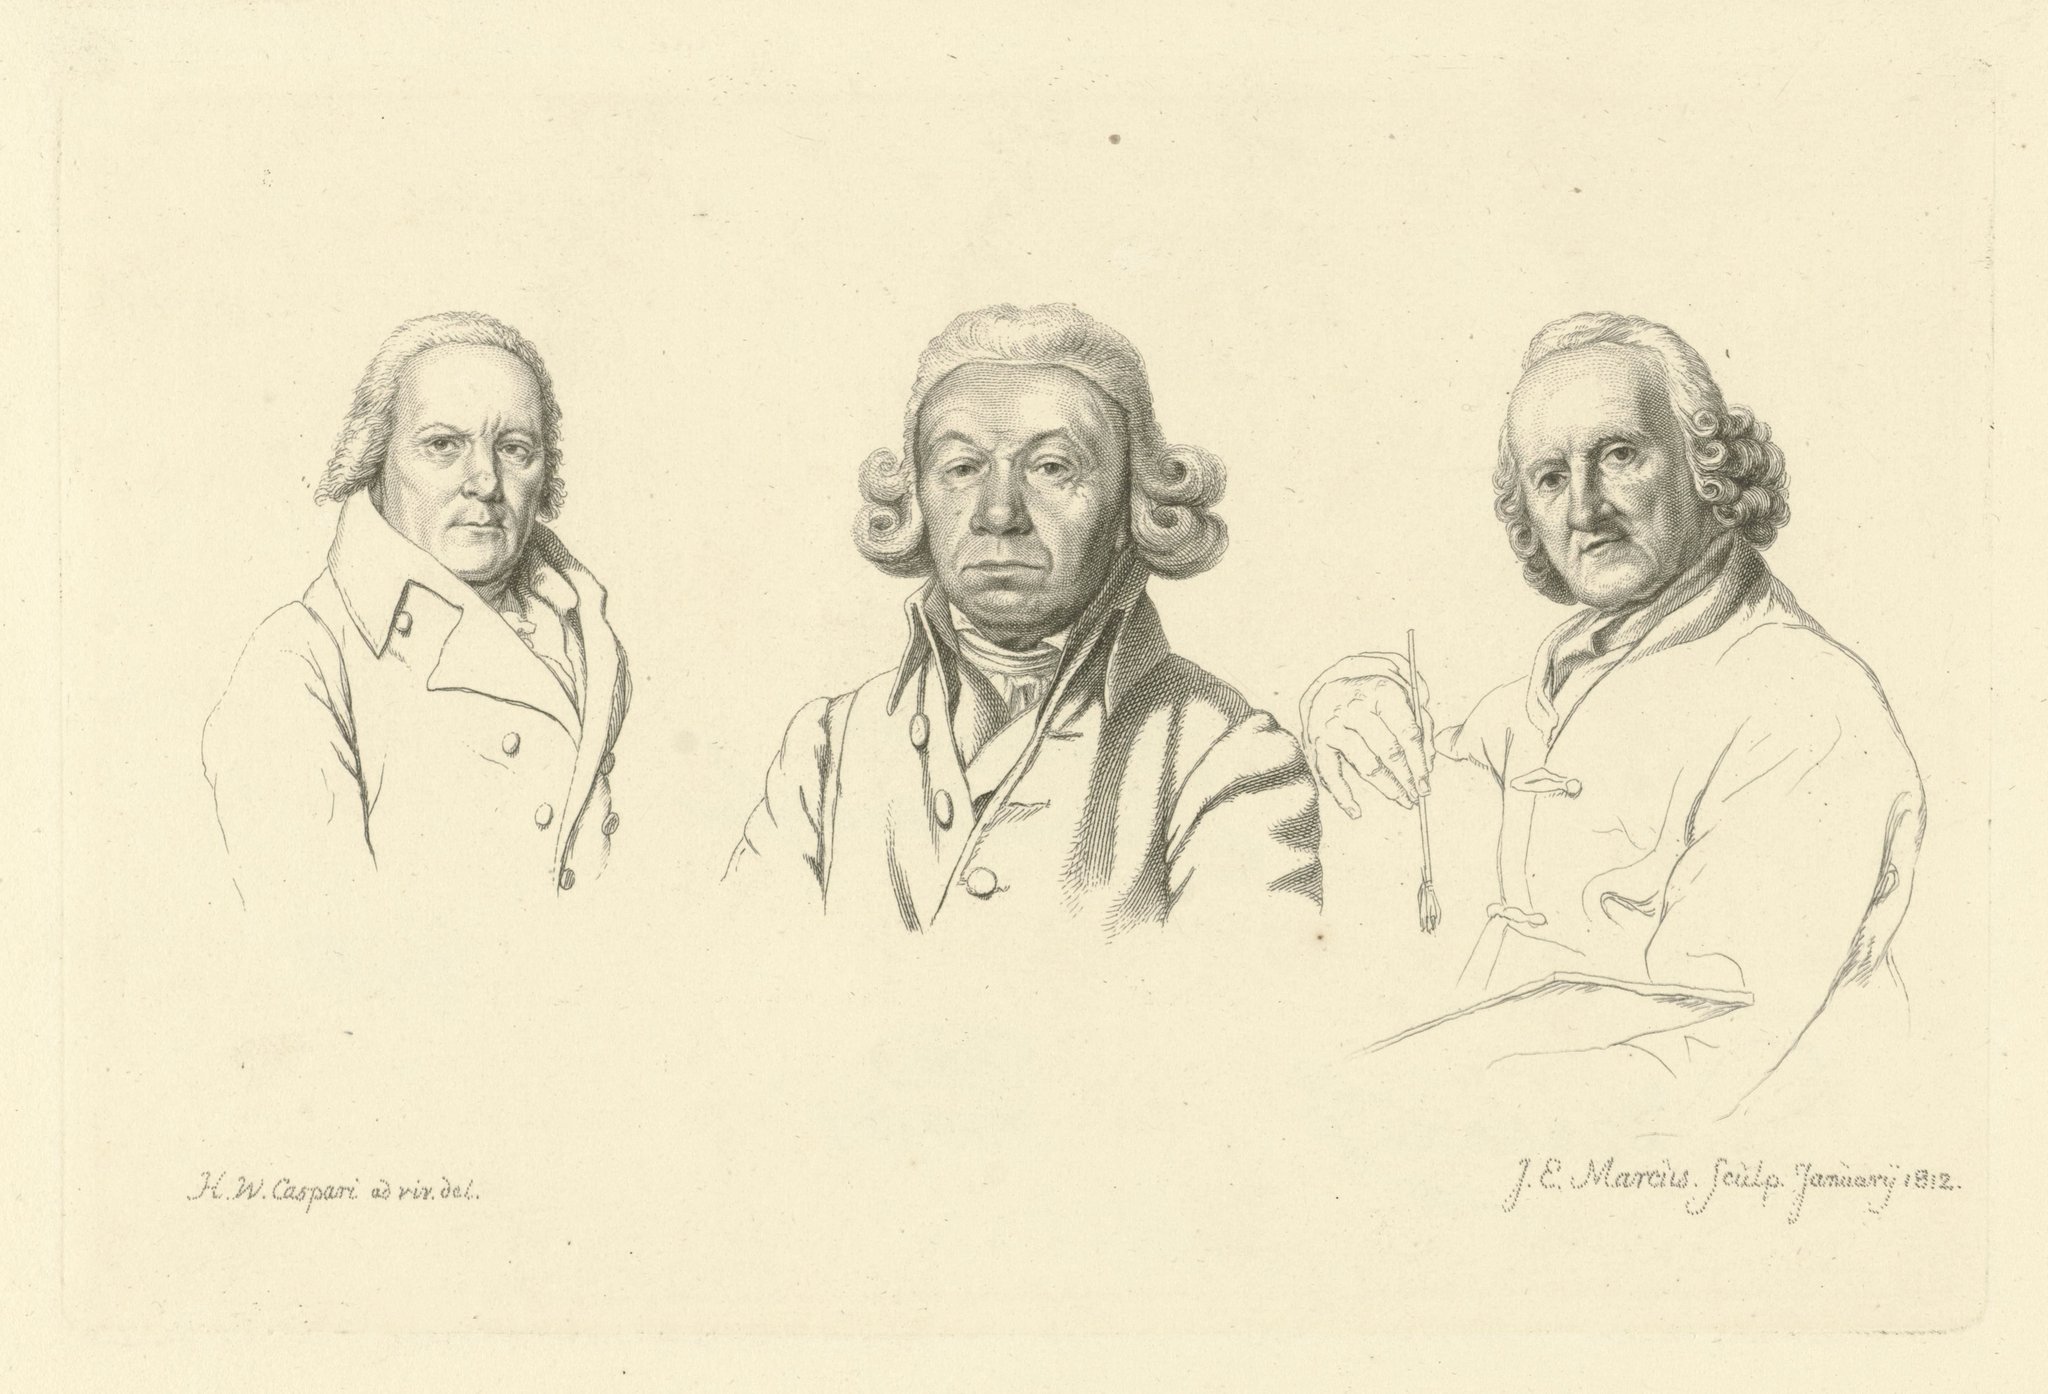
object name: print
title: Portretten van Jacobus Buys, Izaak Schmidt en Jurriaan Andriessen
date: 1812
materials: paper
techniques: engraving, etching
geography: amsterdam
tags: amsterdam, painter, draughtsman, jurriaan andriessen, izaak schmidt, print maker, jacobus buys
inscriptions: collector's mark: Lugt 2228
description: Serie voor het eerst uitgegeven door Jacob Ernst Marcus onder de titel Studiebeelden en Fragmenten. Amsterdam: ca.1816. Later heruitgegeven als: Studie-prentwerk/ Etudes gravées.